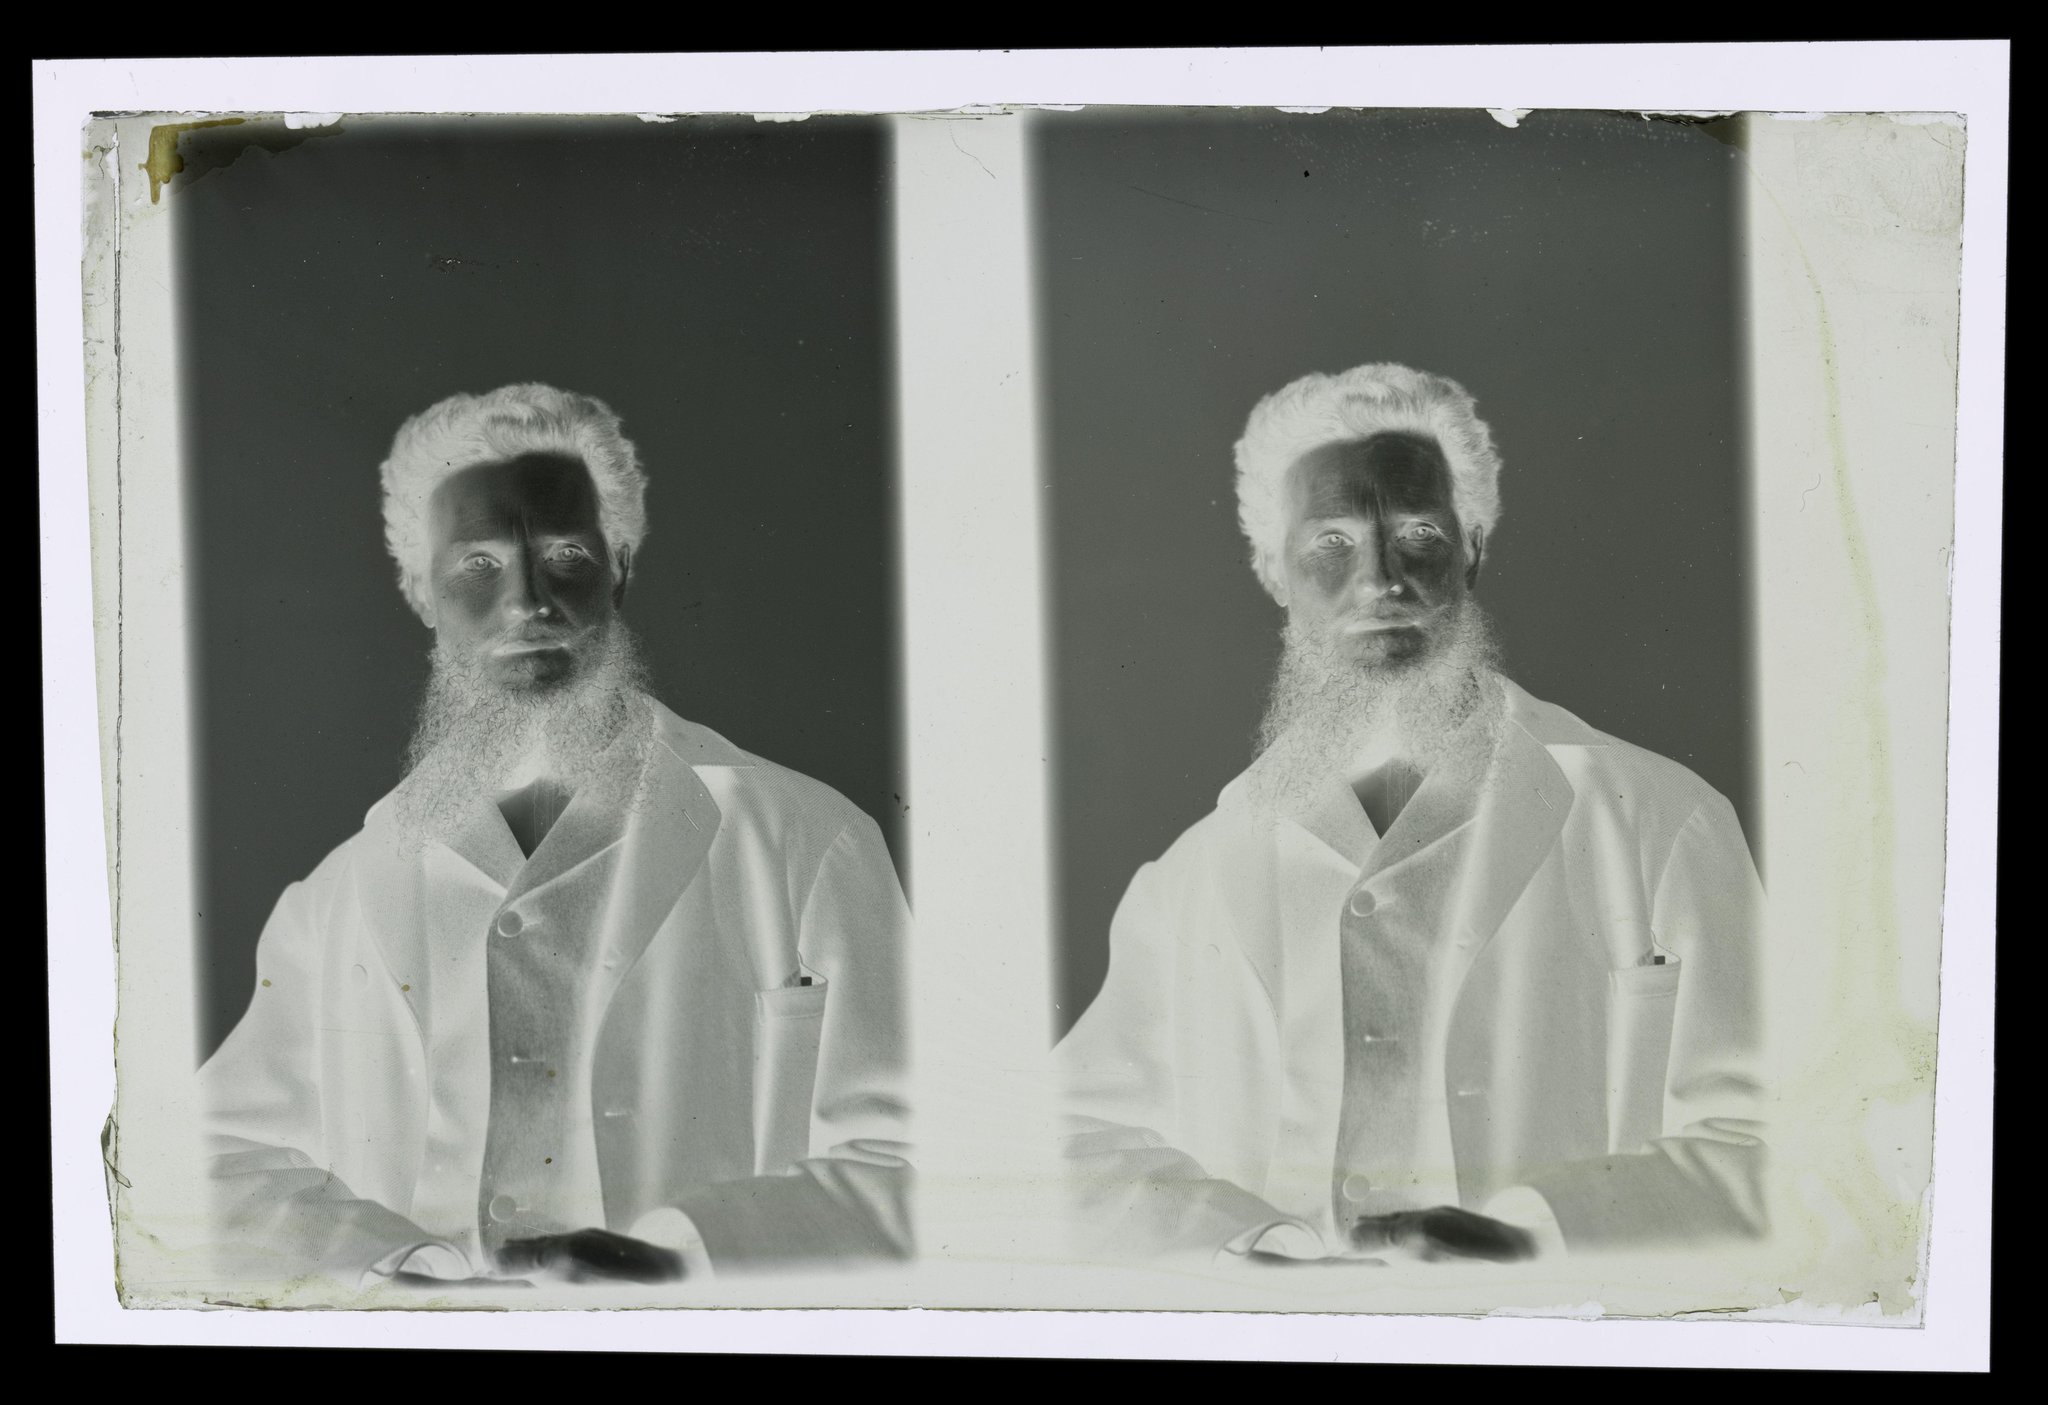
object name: glass negative stereograph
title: Zelfportret van Laurens Lodewijk Kleijn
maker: laurens lodewijk kleijn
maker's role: draughtsman, painter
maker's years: 1826-1909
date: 1865-1900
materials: glass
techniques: collodion process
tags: painter, draughtsman, laurens lodewijk kleijn, historical persons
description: Onderdeel van een groep glasnegatieven uit de nalatenschap van de schilder Laurens Lodewijk Kleijn, met stillevens, portretten, zelfportretten en kunstreproducties.